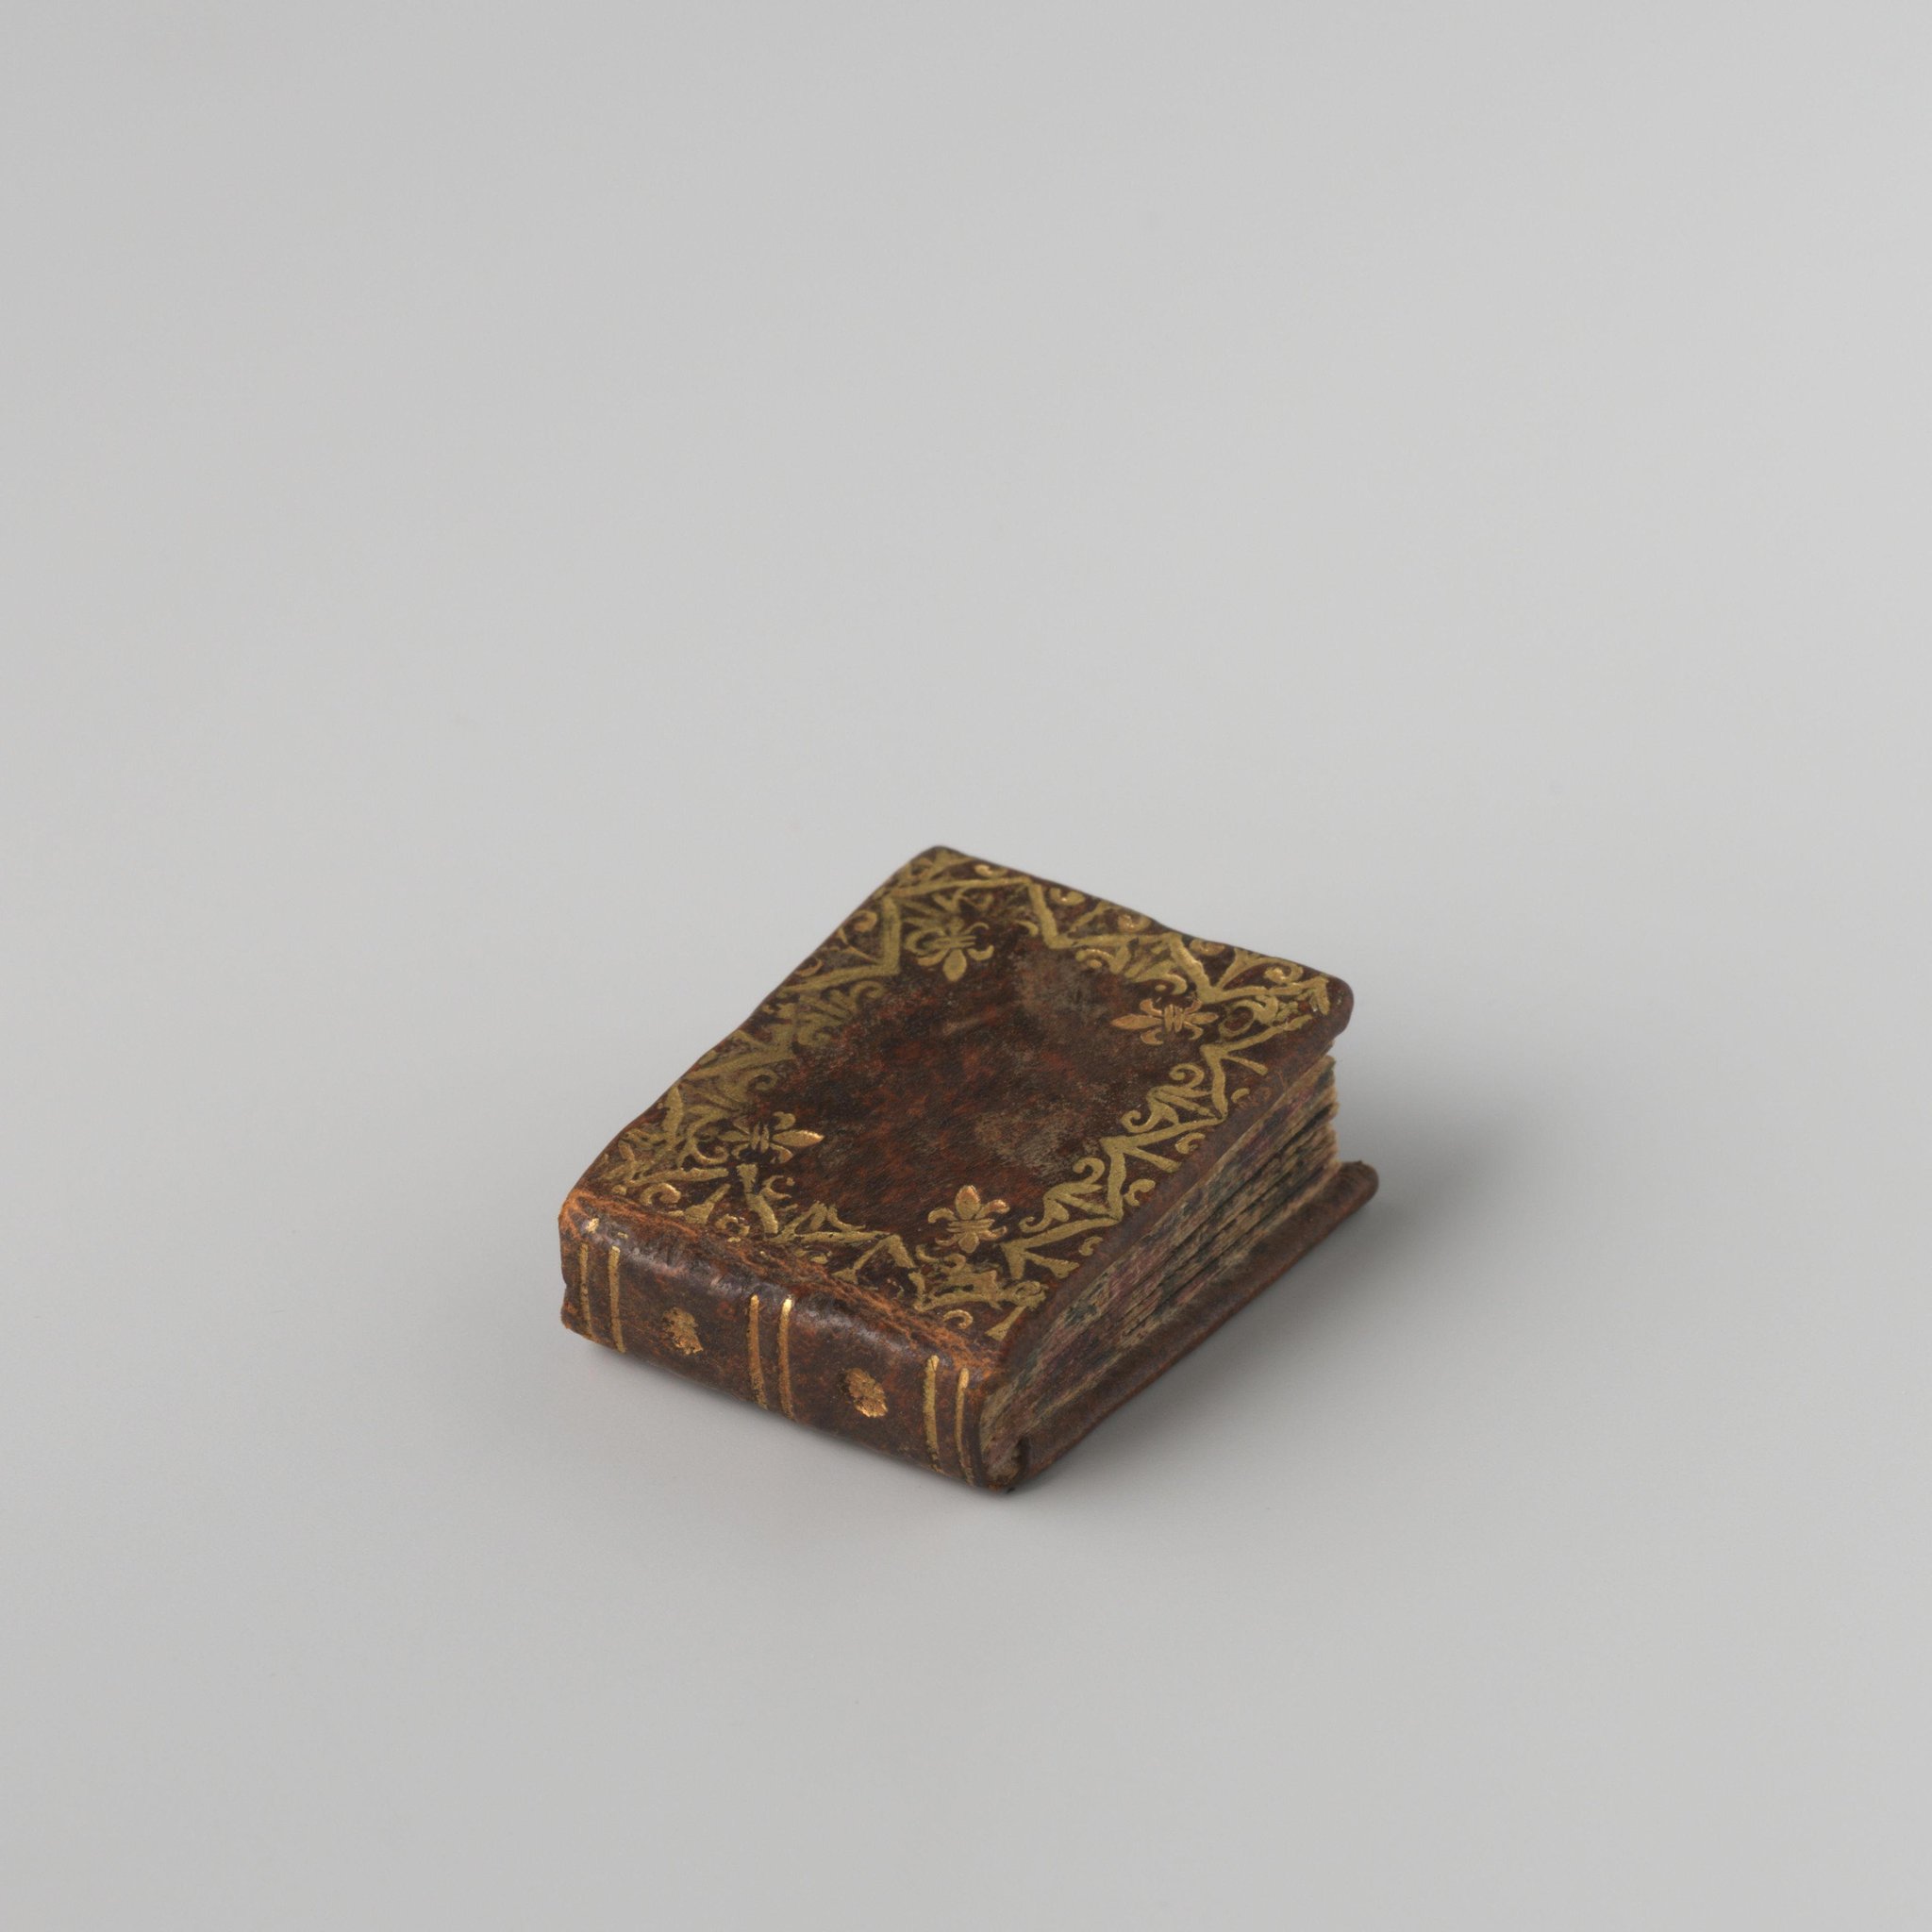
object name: book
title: Boek met figuren en tuingezichten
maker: Anonymous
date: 1690-1710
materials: gold, leather, paper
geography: amsterdam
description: Boek met figuren en tuingezichten. Ingebonden in leer met goudopdruk.